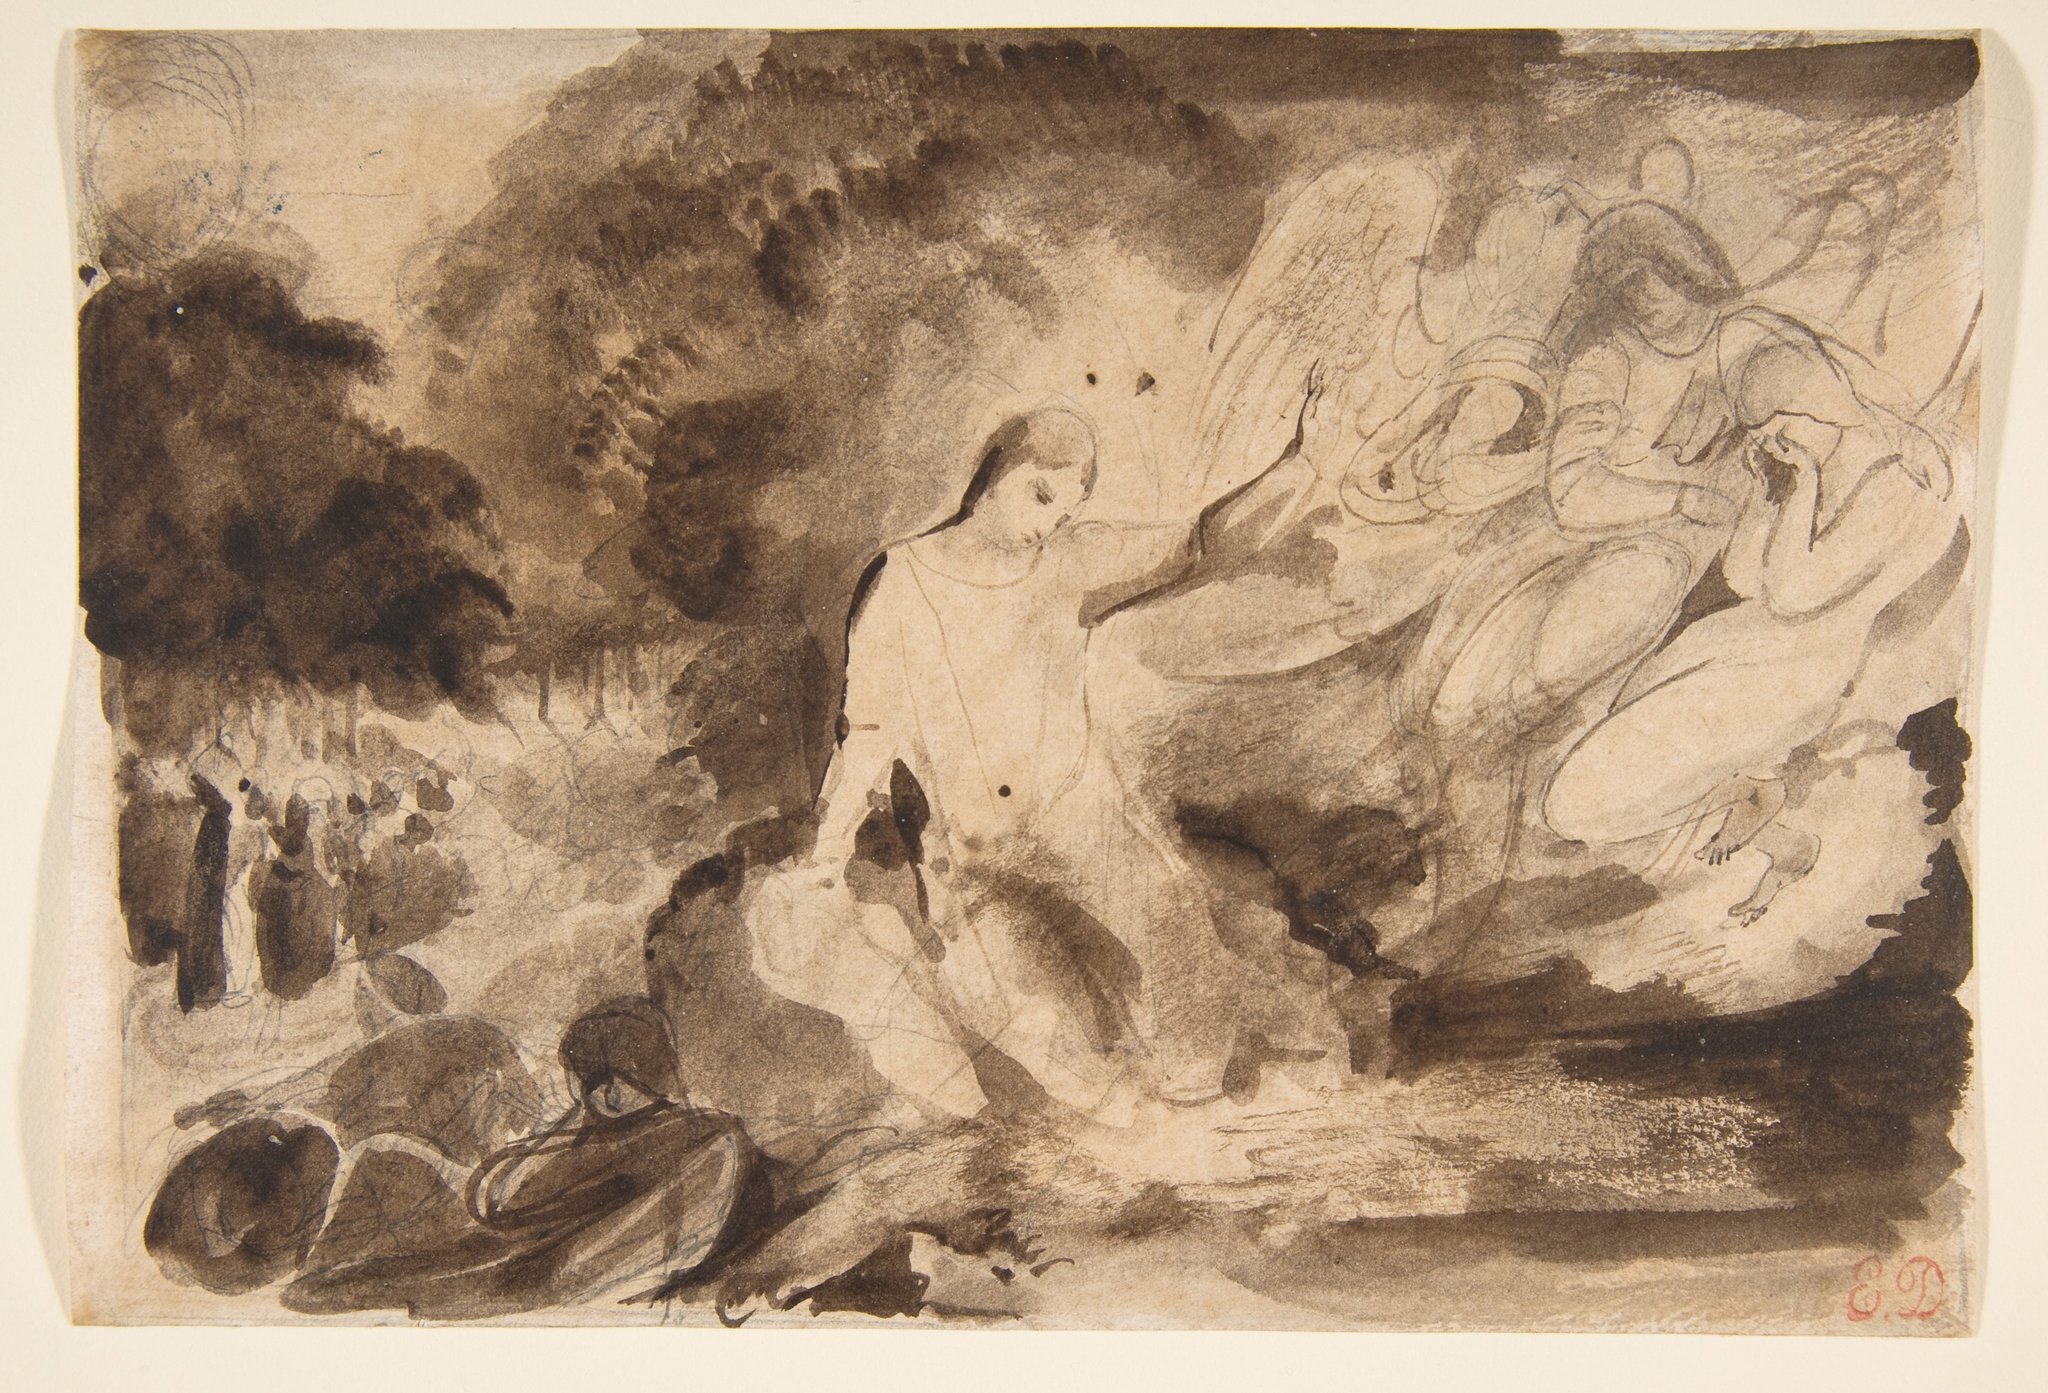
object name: drawing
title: The Agony in the Garden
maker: eugène delacroix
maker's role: artist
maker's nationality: french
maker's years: 1798-1863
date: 1823-1824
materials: graphite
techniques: brush, wash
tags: gardens,christ